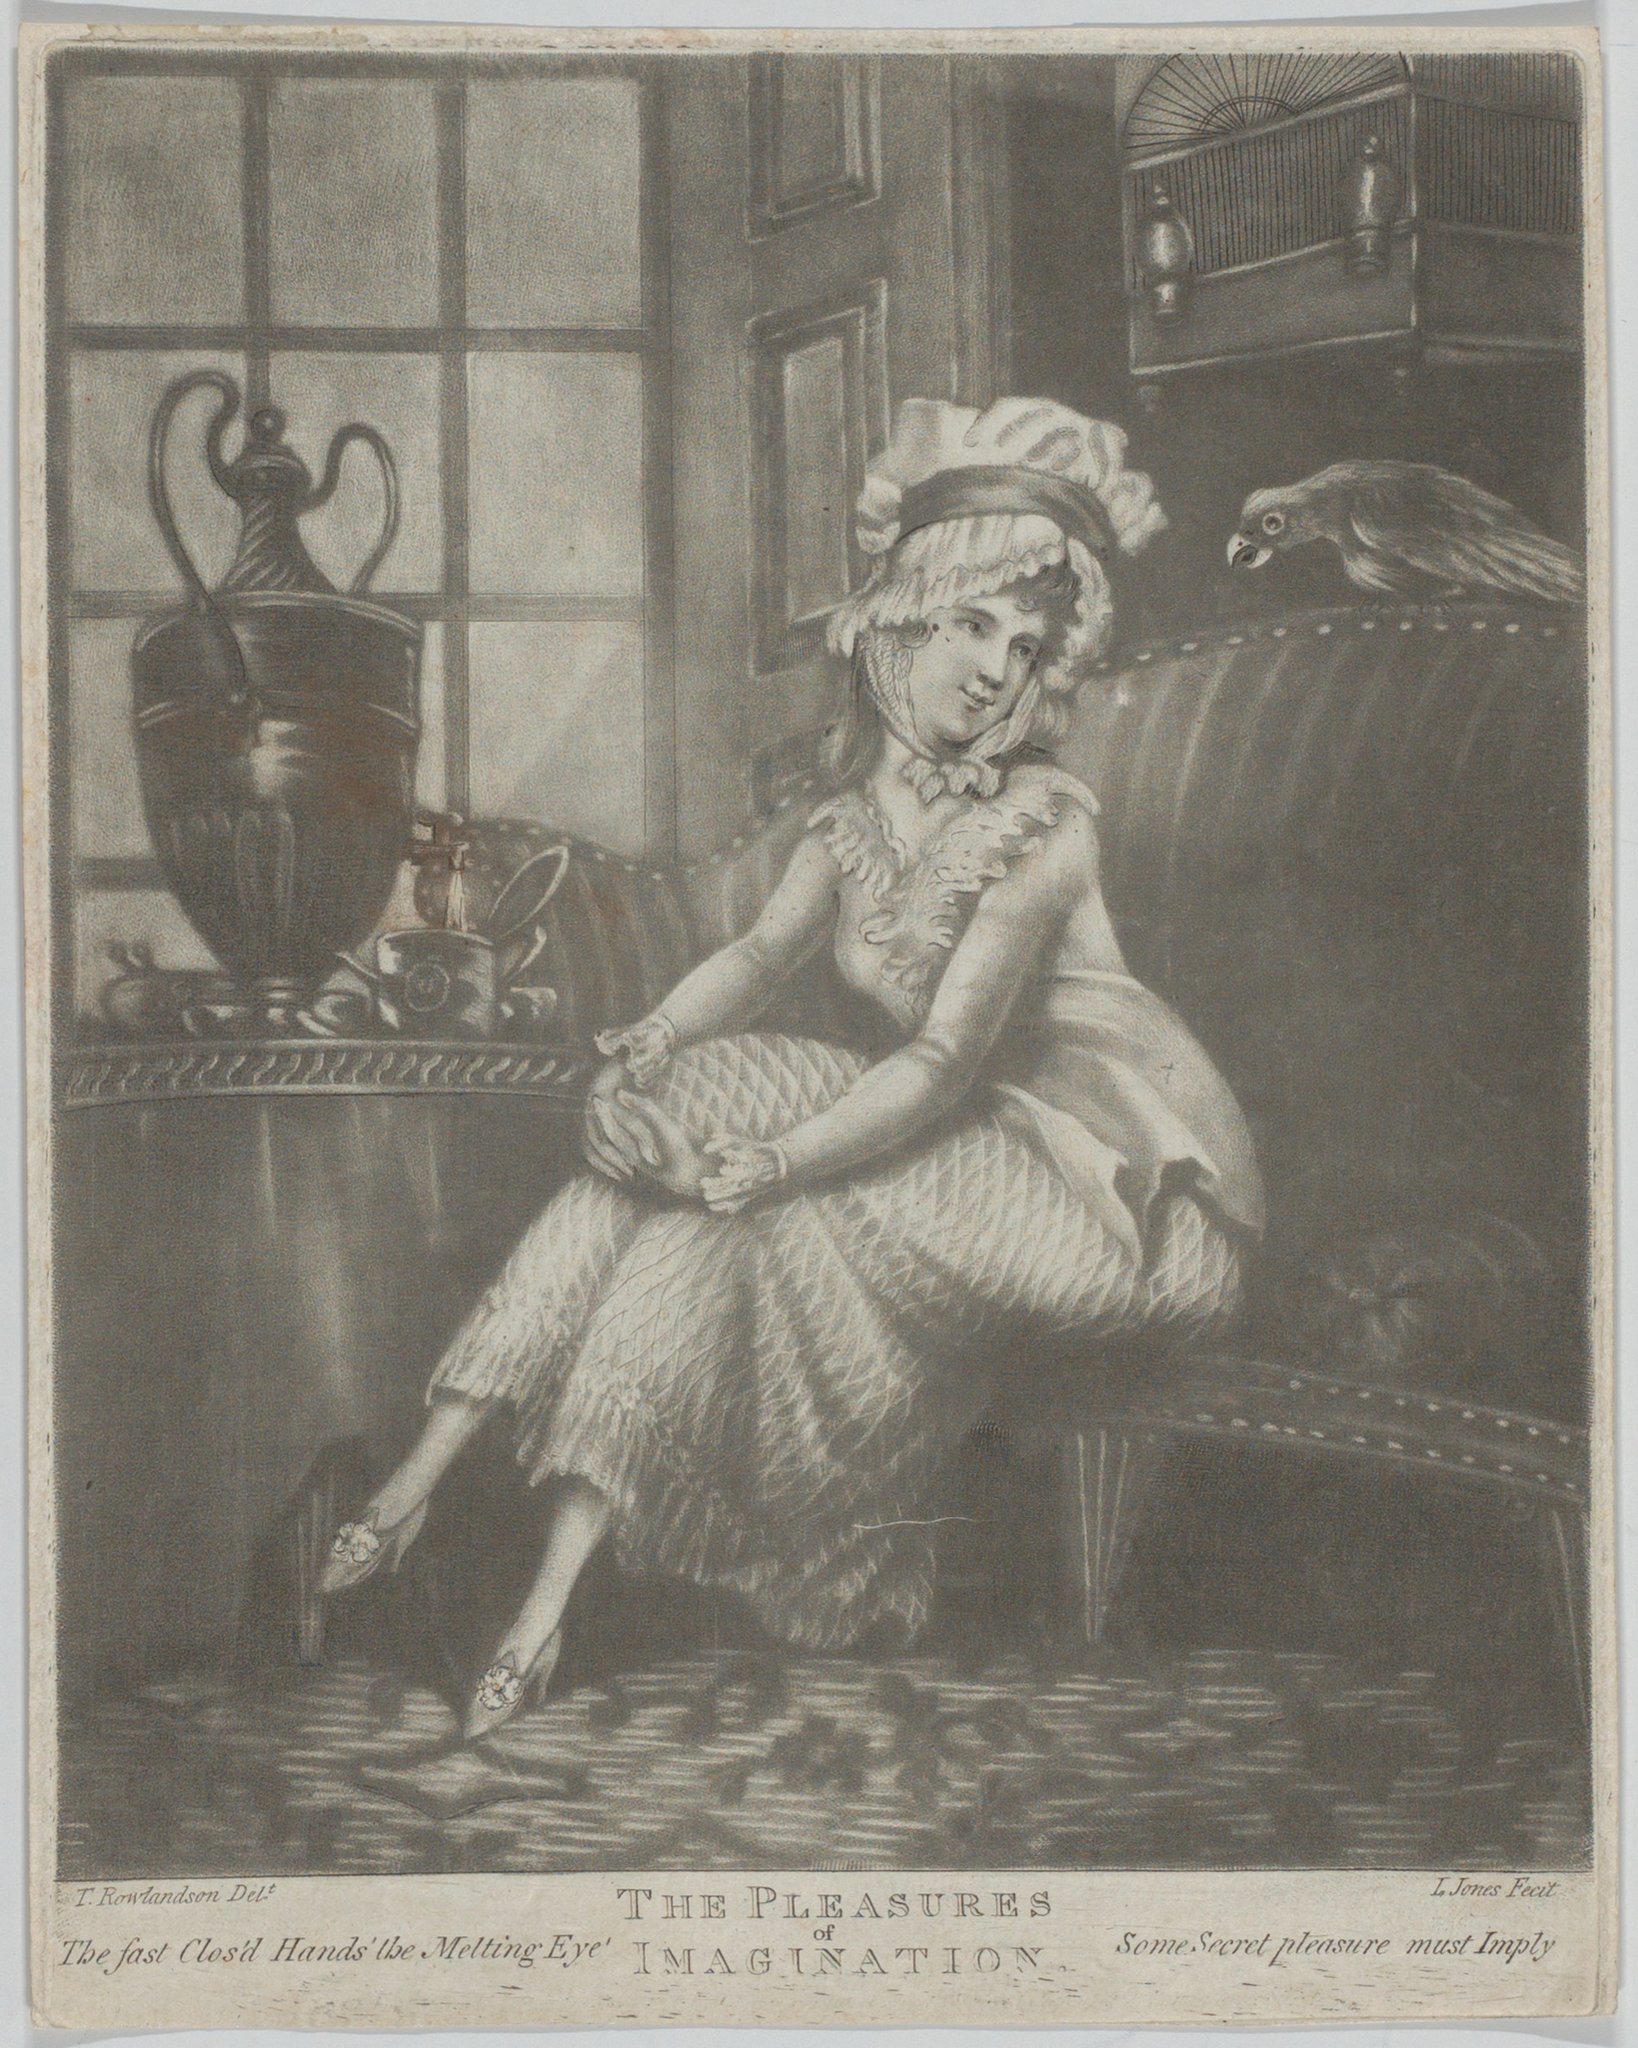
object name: print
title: The Pleasures of Imagination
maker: thomas rowlandson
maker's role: artist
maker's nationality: british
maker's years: 1757-1827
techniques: mezzotint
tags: women,parrots